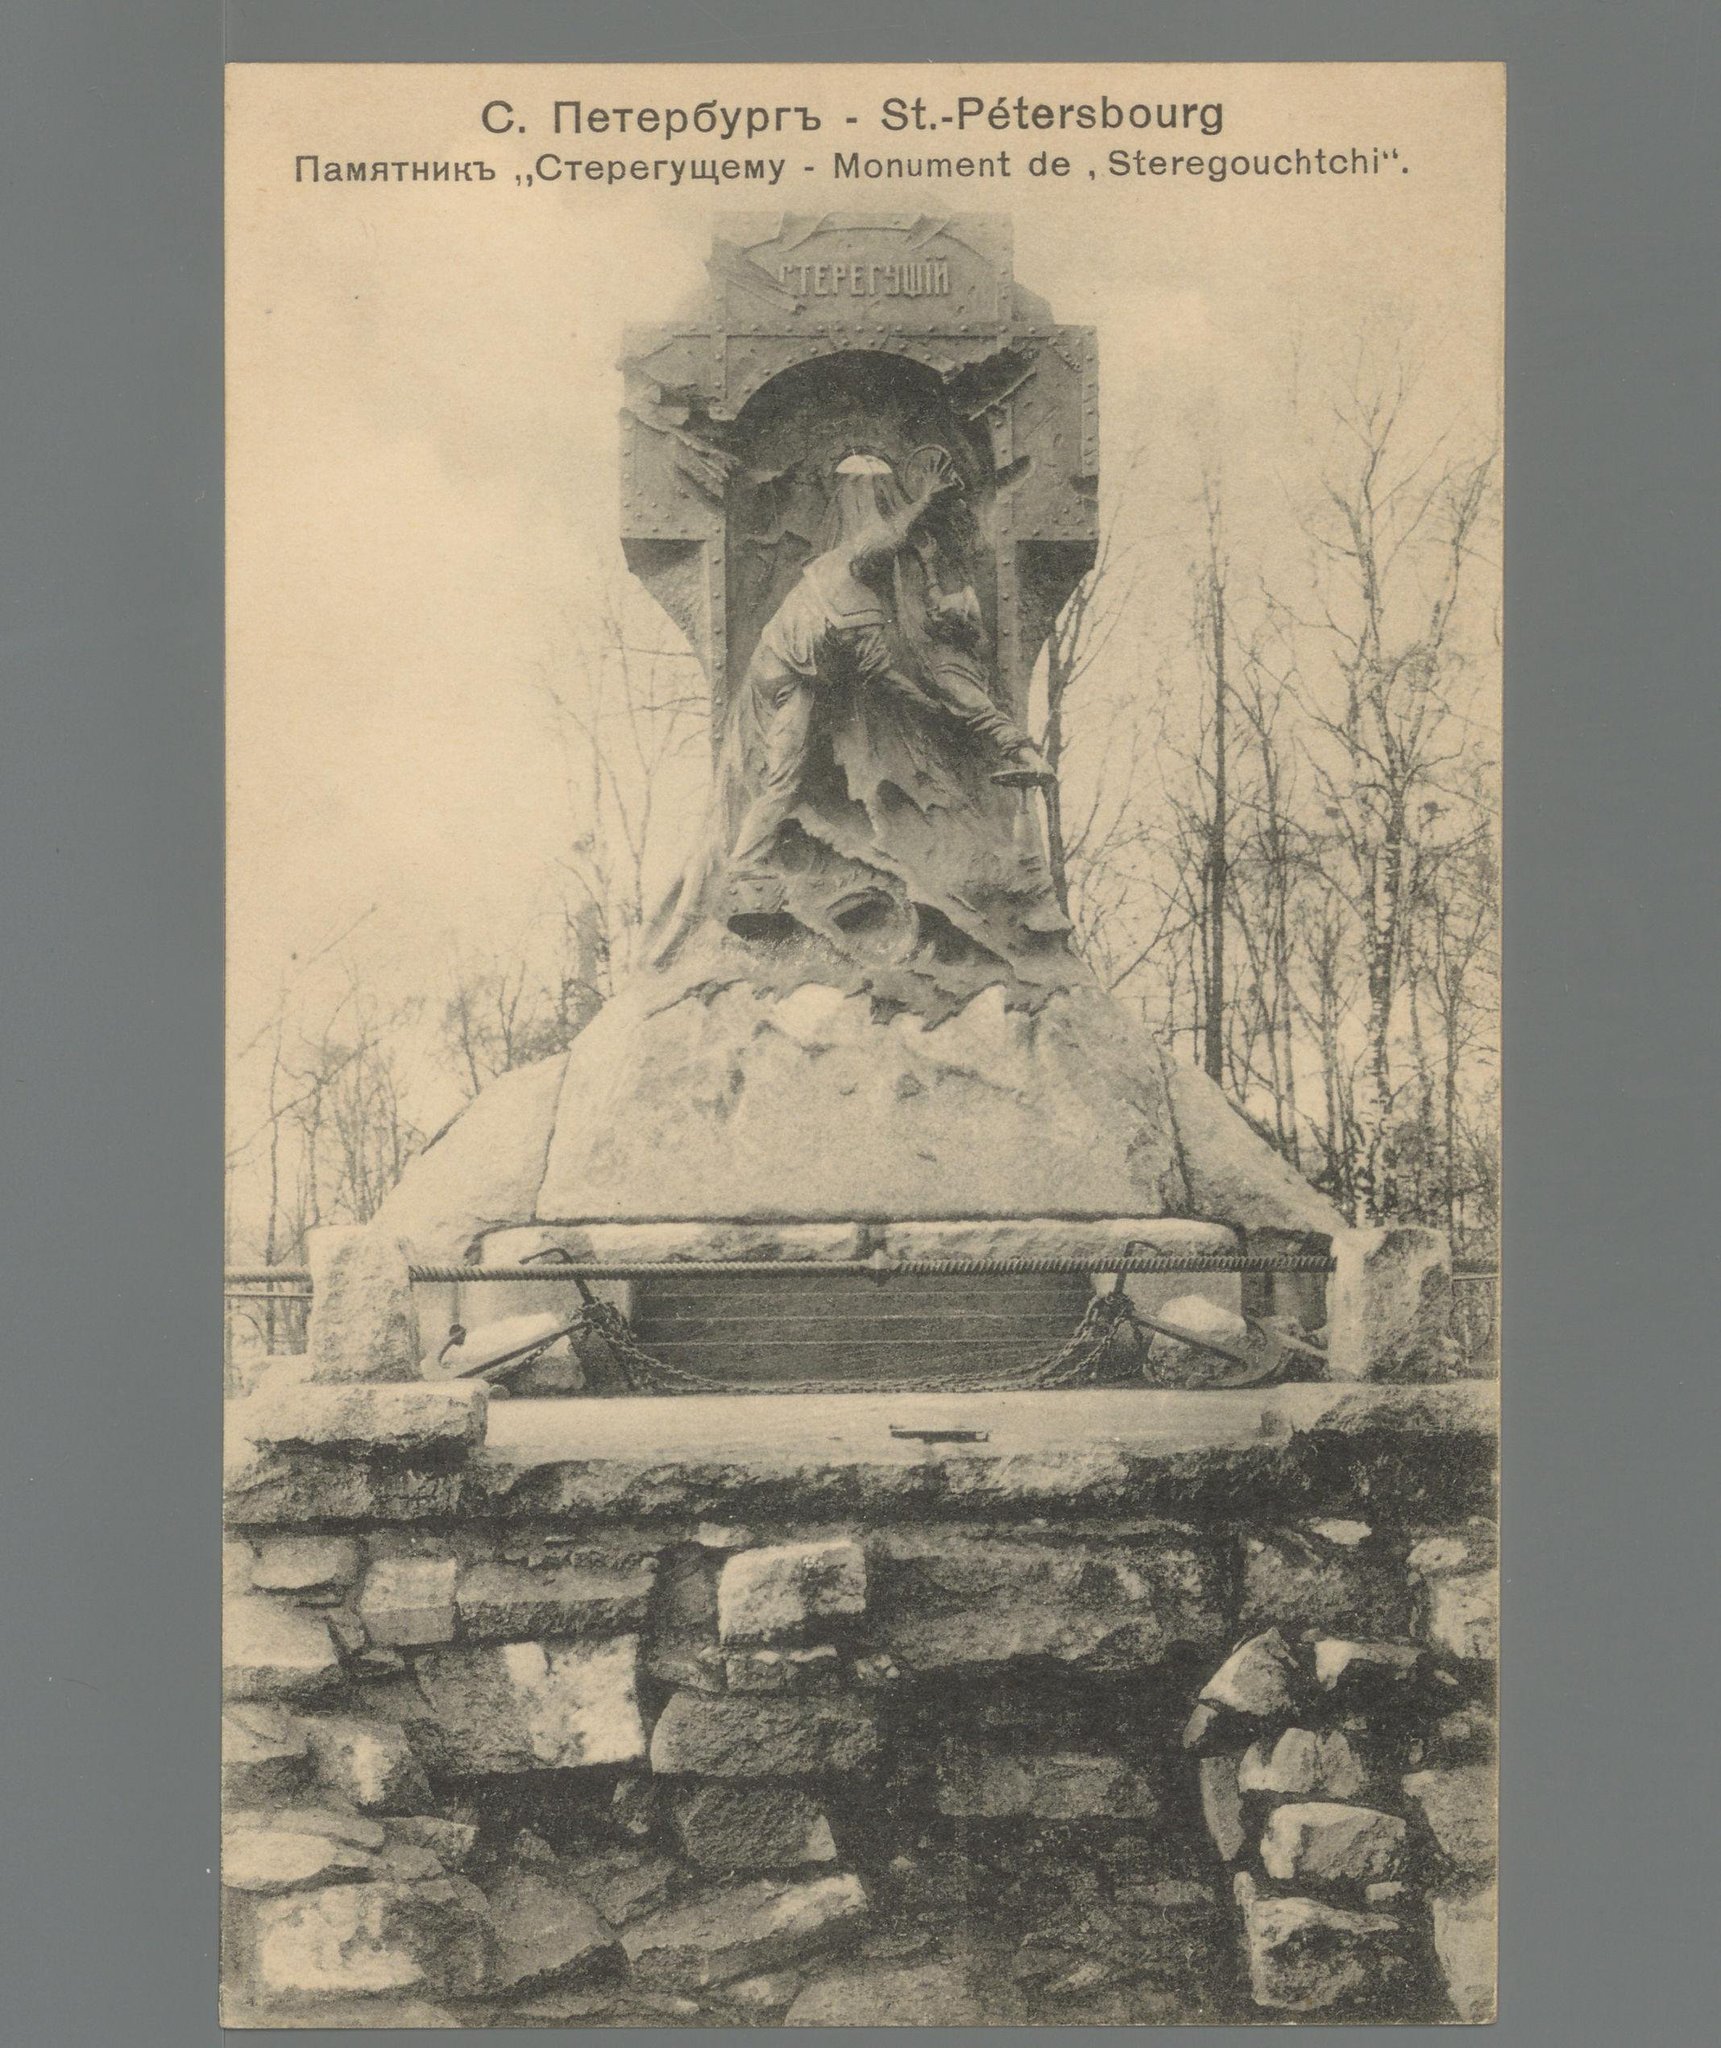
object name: photomechanical print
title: St.-Pétersbourg. Monument de 'Steregouchtchi'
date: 1911-1930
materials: cardboard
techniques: photograph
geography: sint-petersburg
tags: monument, statue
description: Voor de Franse titel staat de titel in het Russisch.